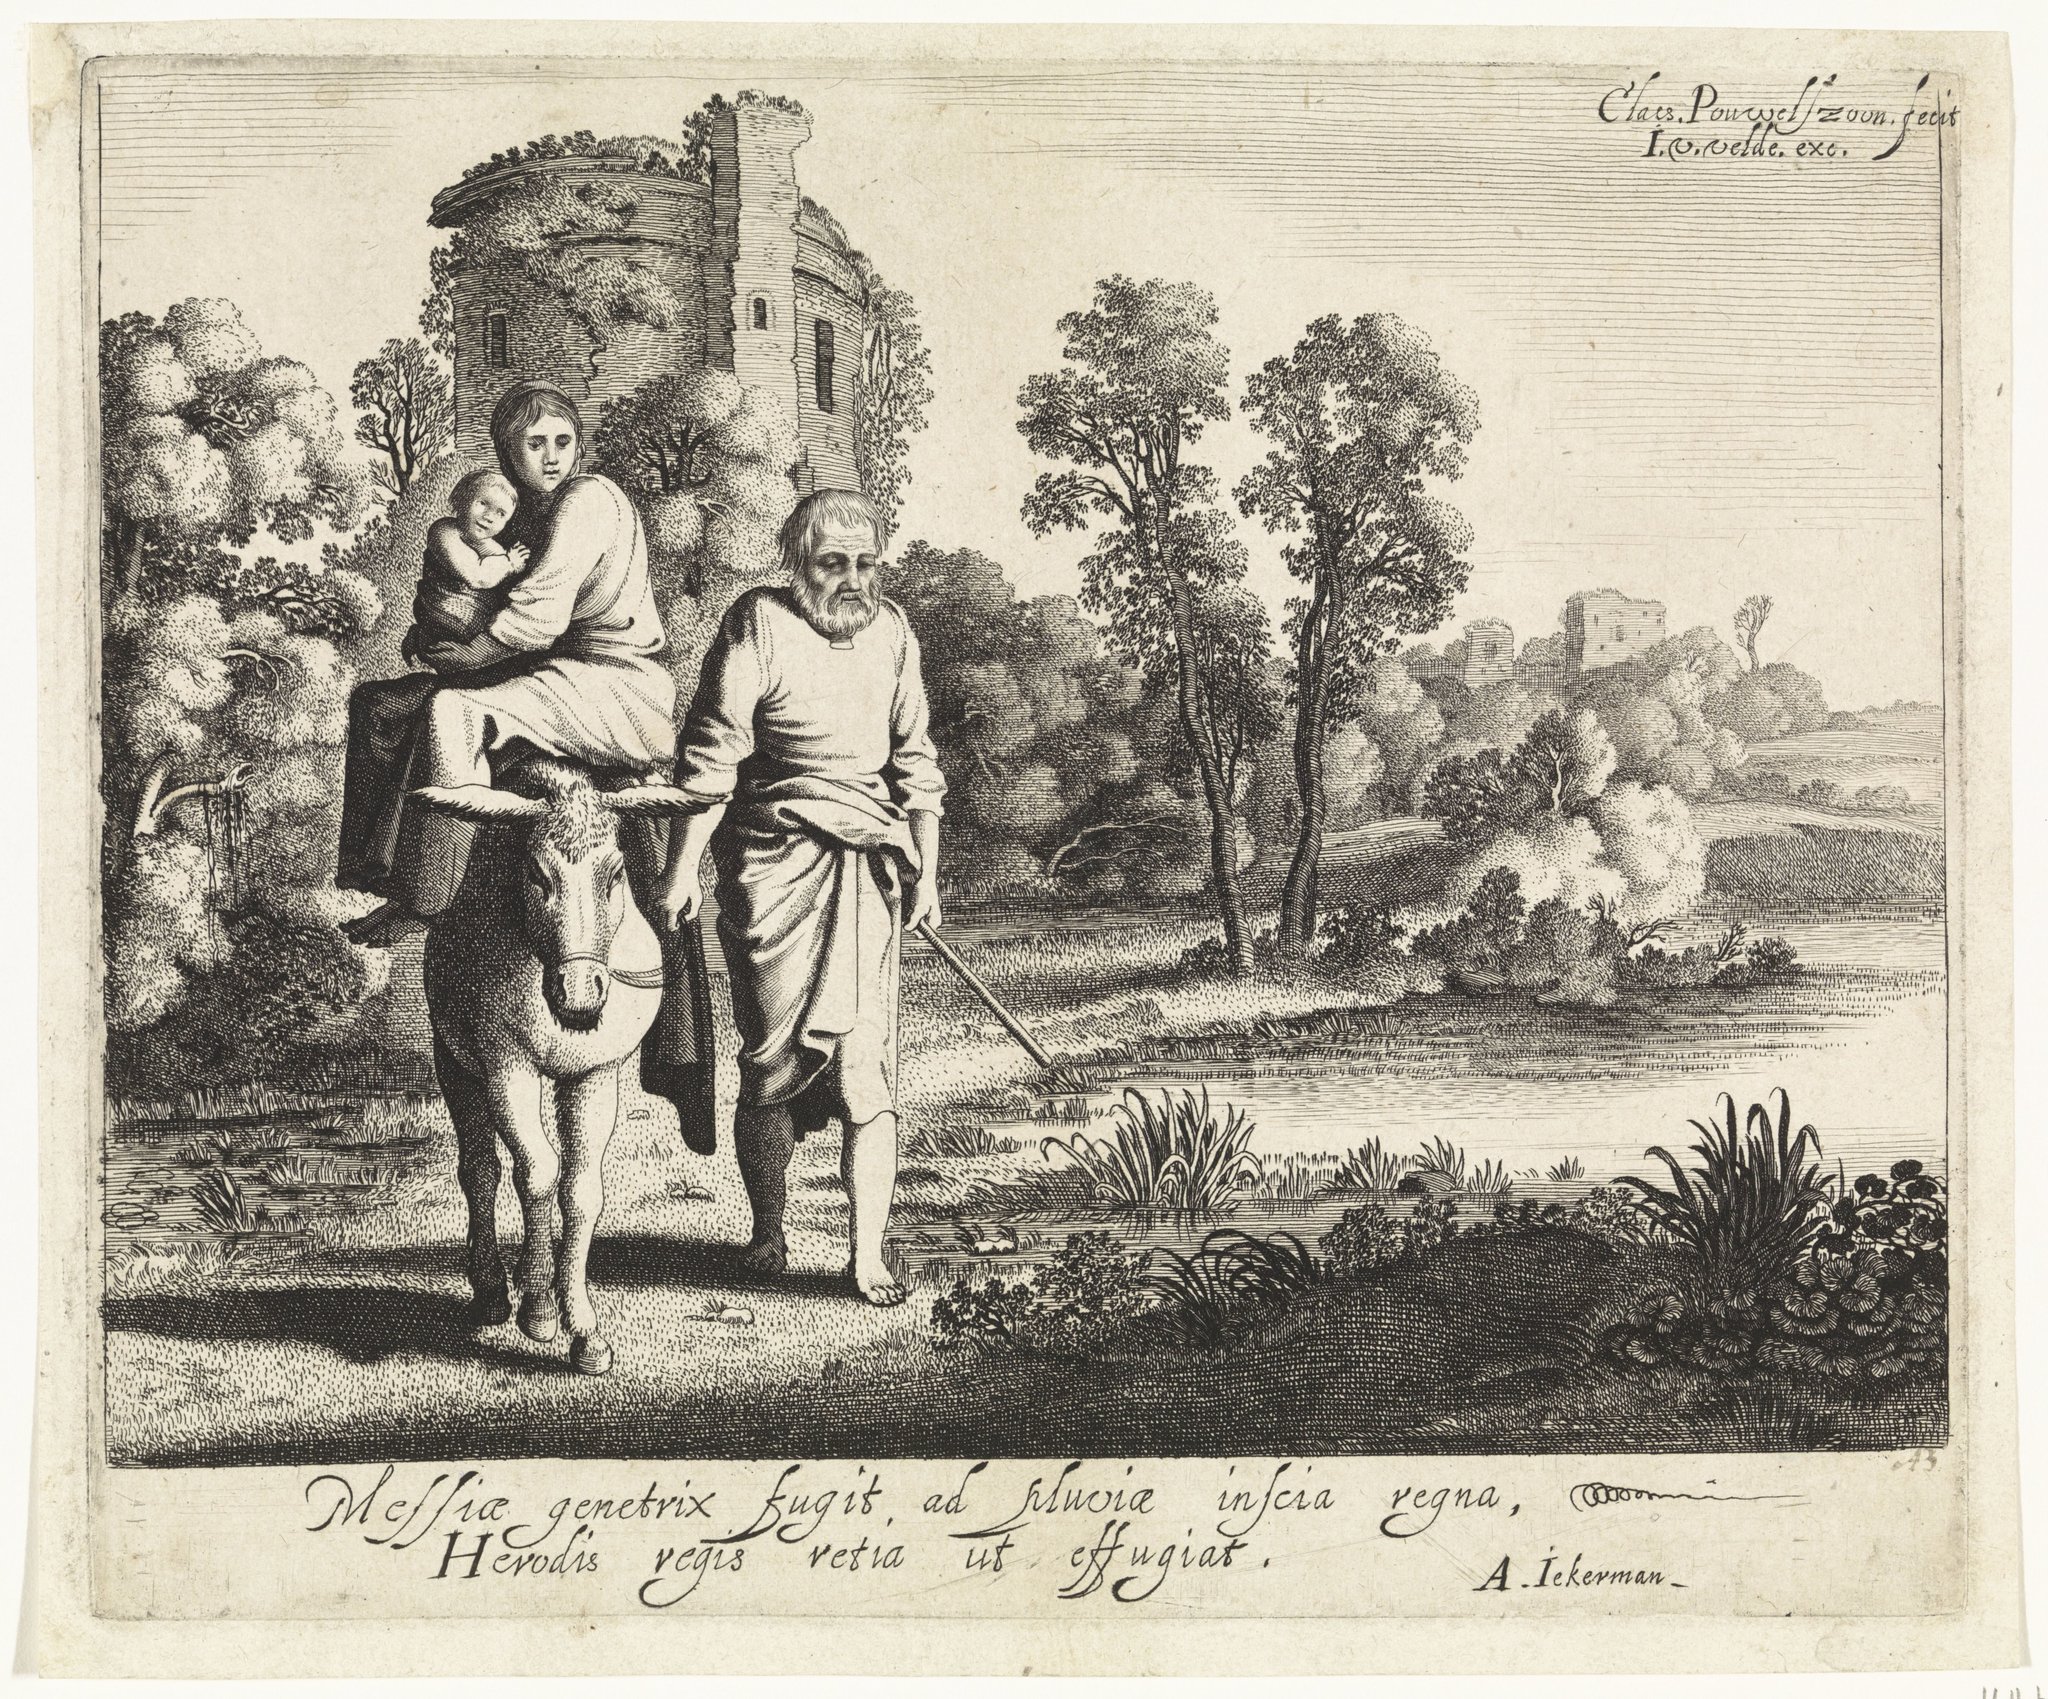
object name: print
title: Landschap met de vlucht naar Egypte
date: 1615-1641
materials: paper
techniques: engraving, etching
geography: northern netherlands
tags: the flight into egypt: mary, joseph, the child (and sometimes others) on their way; mary usually riding on an ass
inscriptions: inscription: ‘Du Cab[ine]t Bordage’, collector's mark: Lugt 2166, collector's mark: Lugt 2760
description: In een landschap met ruïnes leidt Jozef de ezel met daarop Maria die het Christuskind in haar armen houdt. In de marge twee dichtregels in het Latijn.